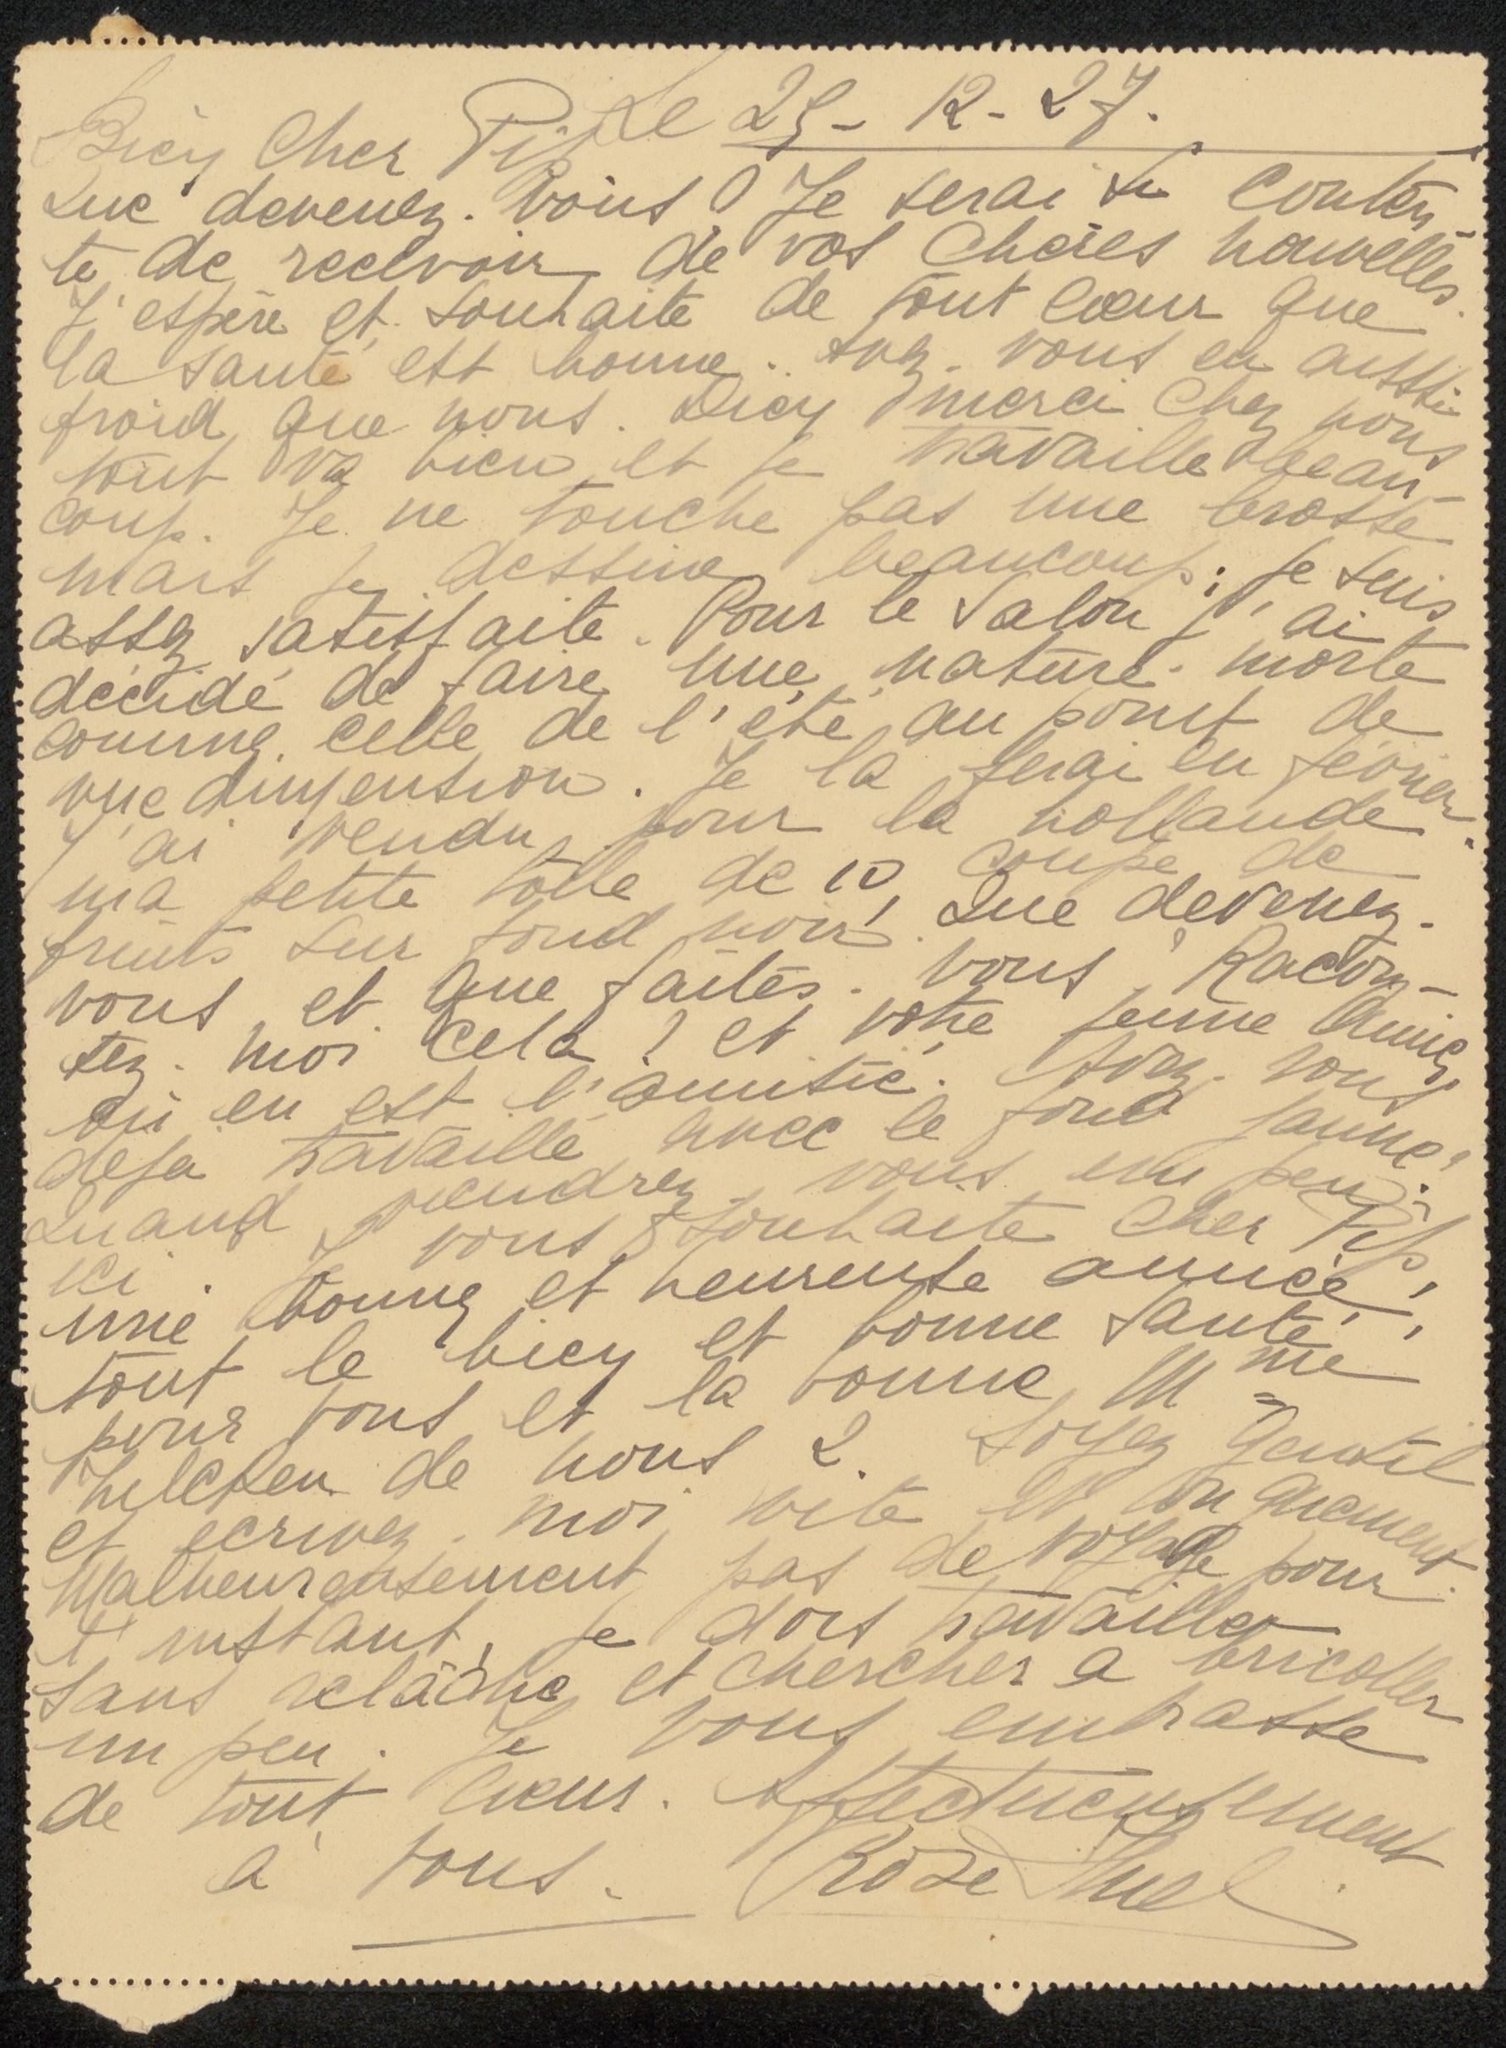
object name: letter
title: Brief aan Philip Zilcken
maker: rose imel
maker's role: draughtsman, painter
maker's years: 1901-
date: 1927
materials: ink, paper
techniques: pen, writing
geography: paris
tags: painter, draughtsman, philip zilcken, art trade, art shop, drawing, painting (including book-illumination, miniature-painting), exhibition ~ art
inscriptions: collector's mark: ‘RPK’